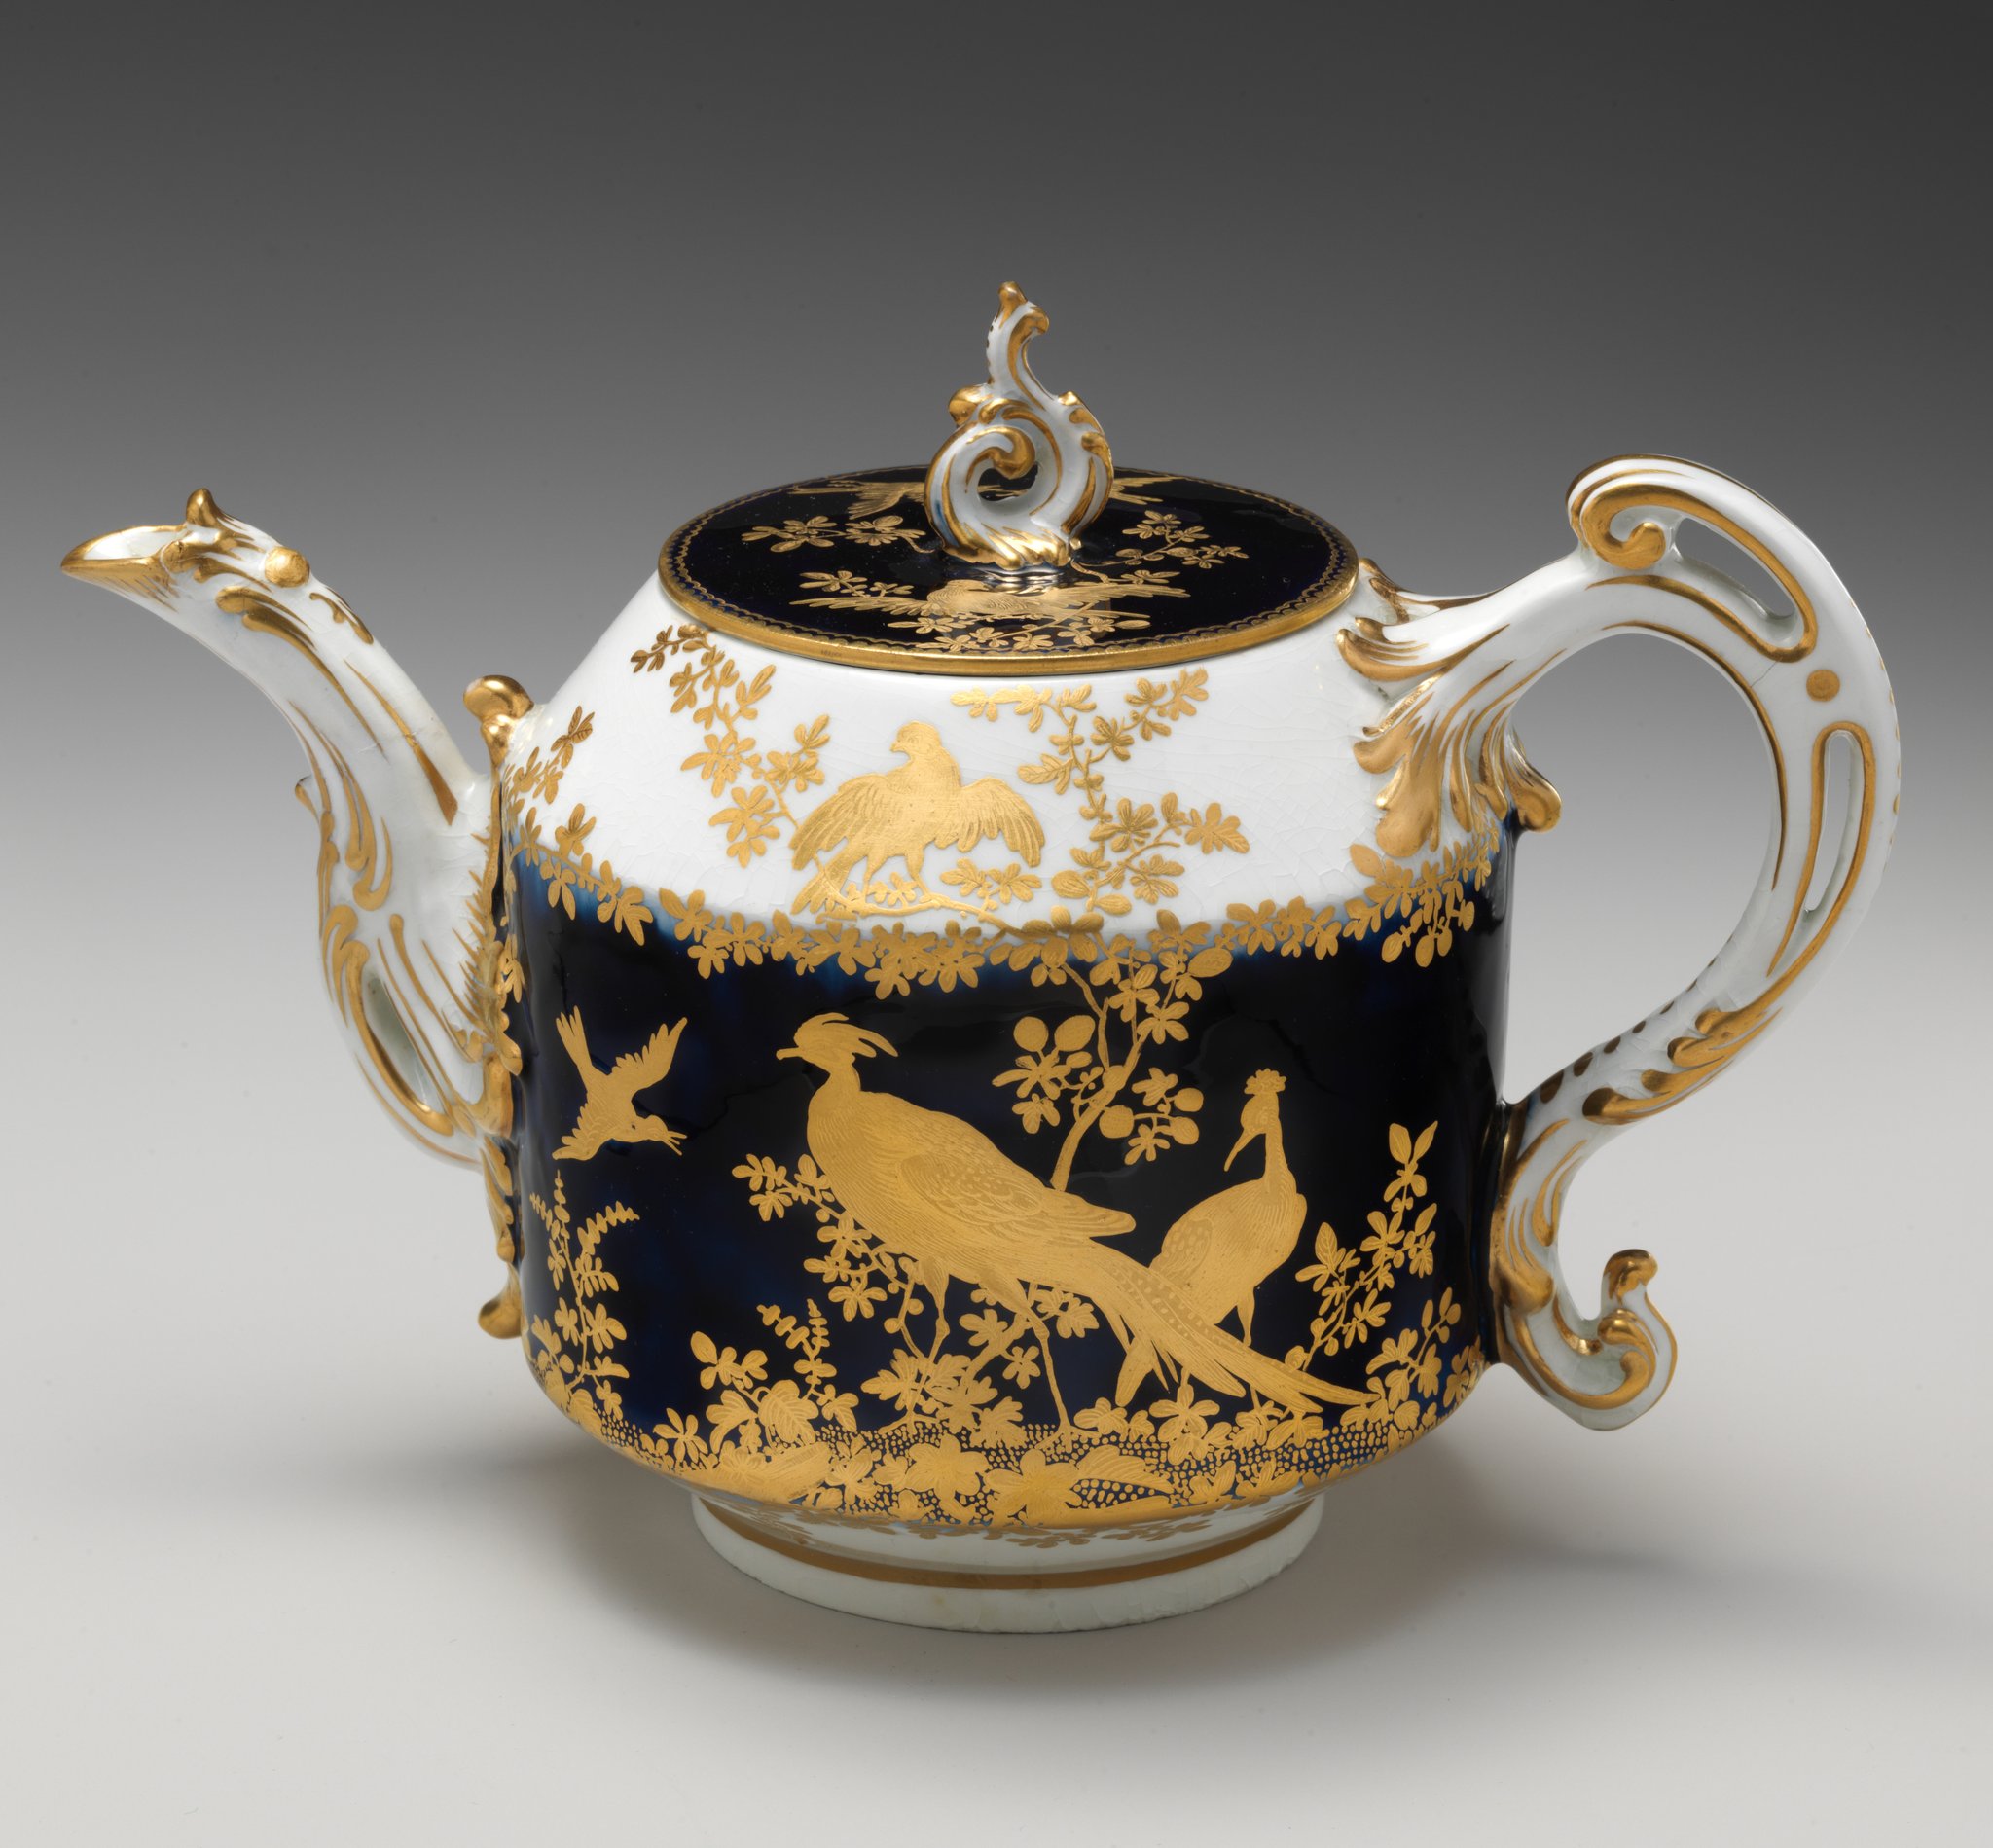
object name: teapot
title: Teapot (part of a service)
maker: chelsea porcelain manufactory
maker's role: factory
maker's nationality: british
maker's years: 1744-1784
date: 1758-1769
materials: enamel, soft paste porcelain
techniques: gilding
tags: birds,leaves